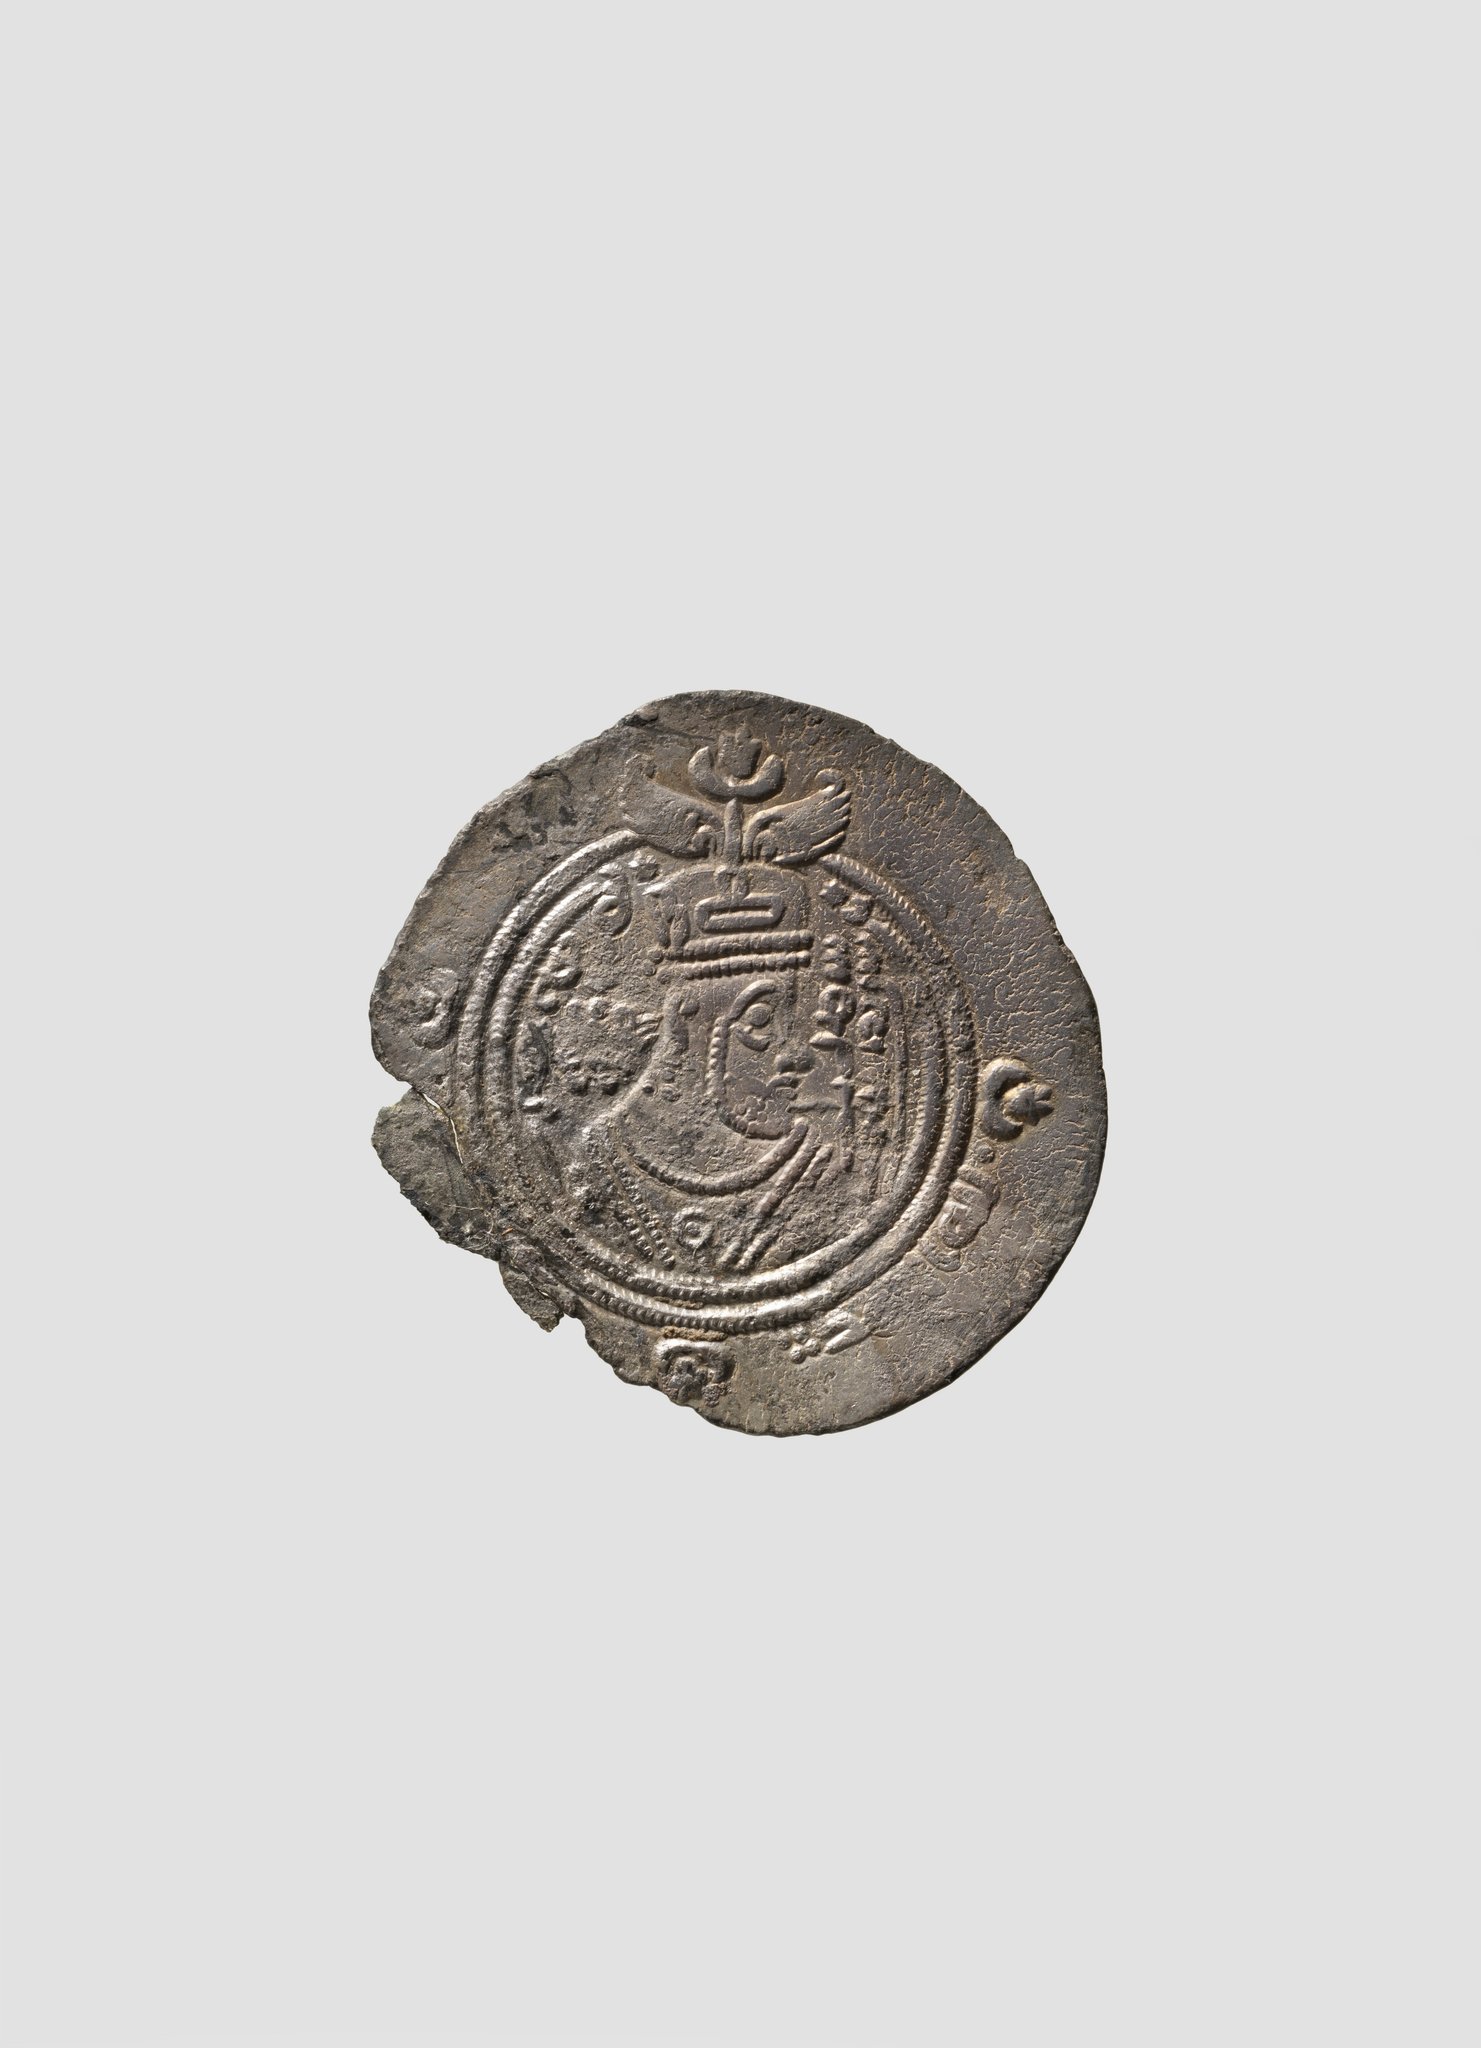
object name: coin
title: Dirhem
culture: islamic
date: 689-690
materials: silver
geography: iran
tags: men